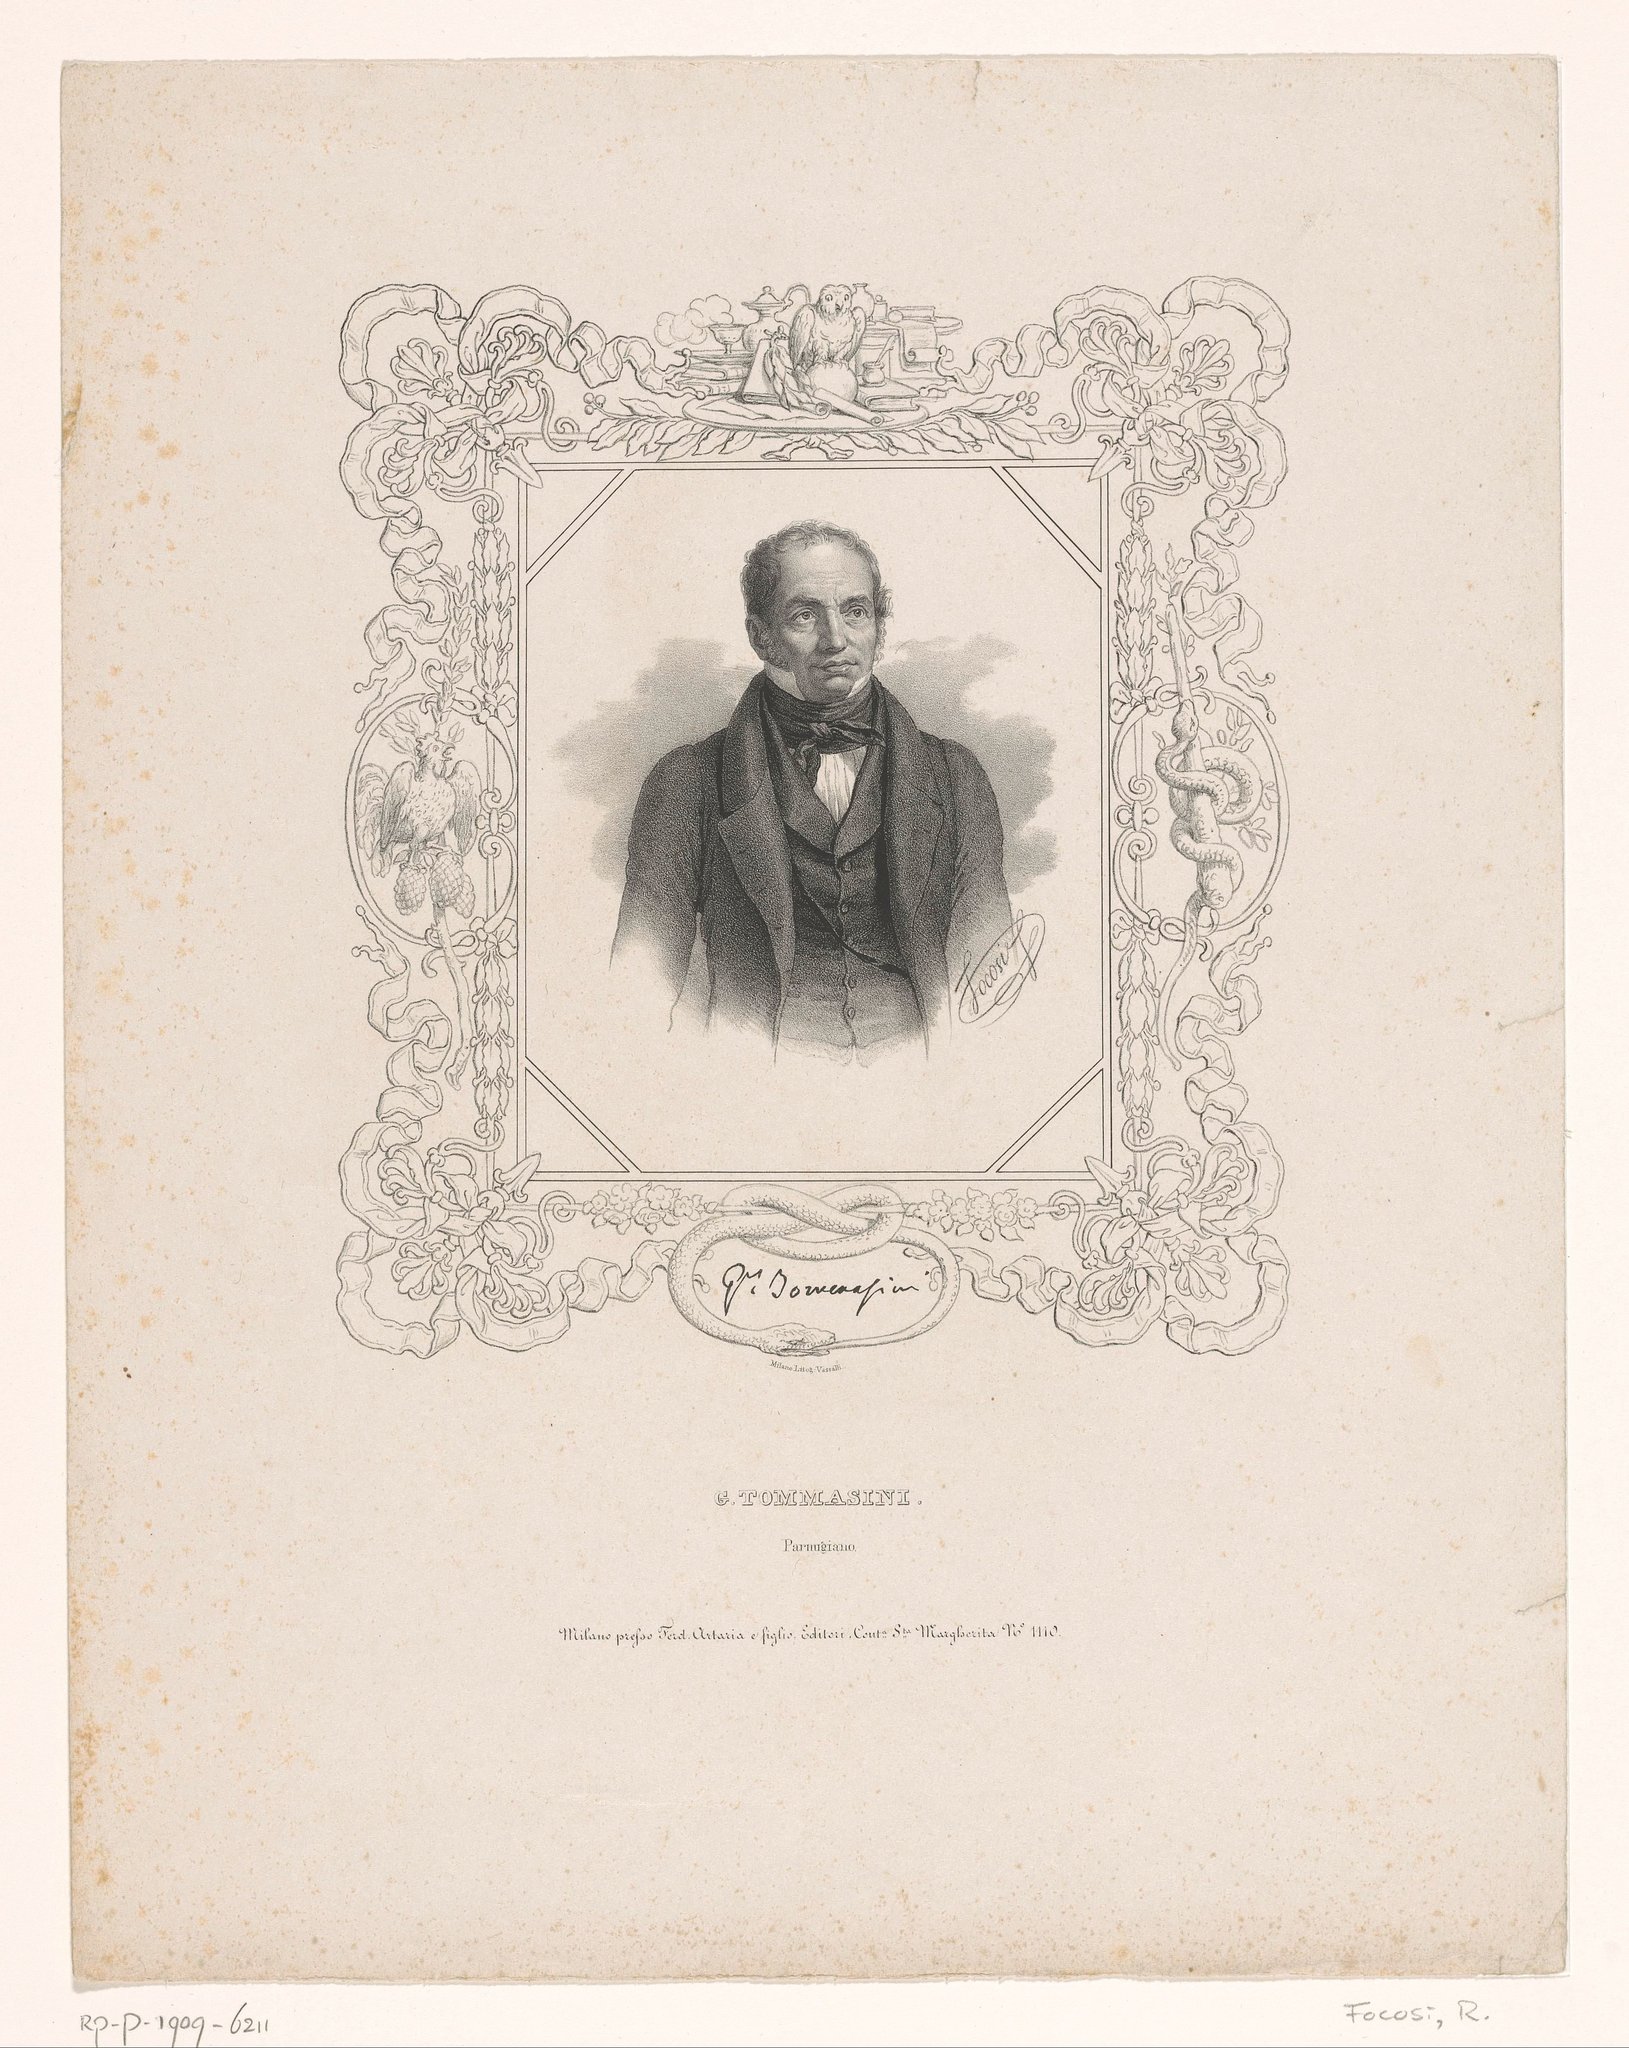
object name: print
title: Portret van medicus Giacomo Tommasini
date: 1816-1862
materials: paper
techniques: lithograph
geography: italy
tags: historical persons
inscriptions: collector's mark: Lugt 2228